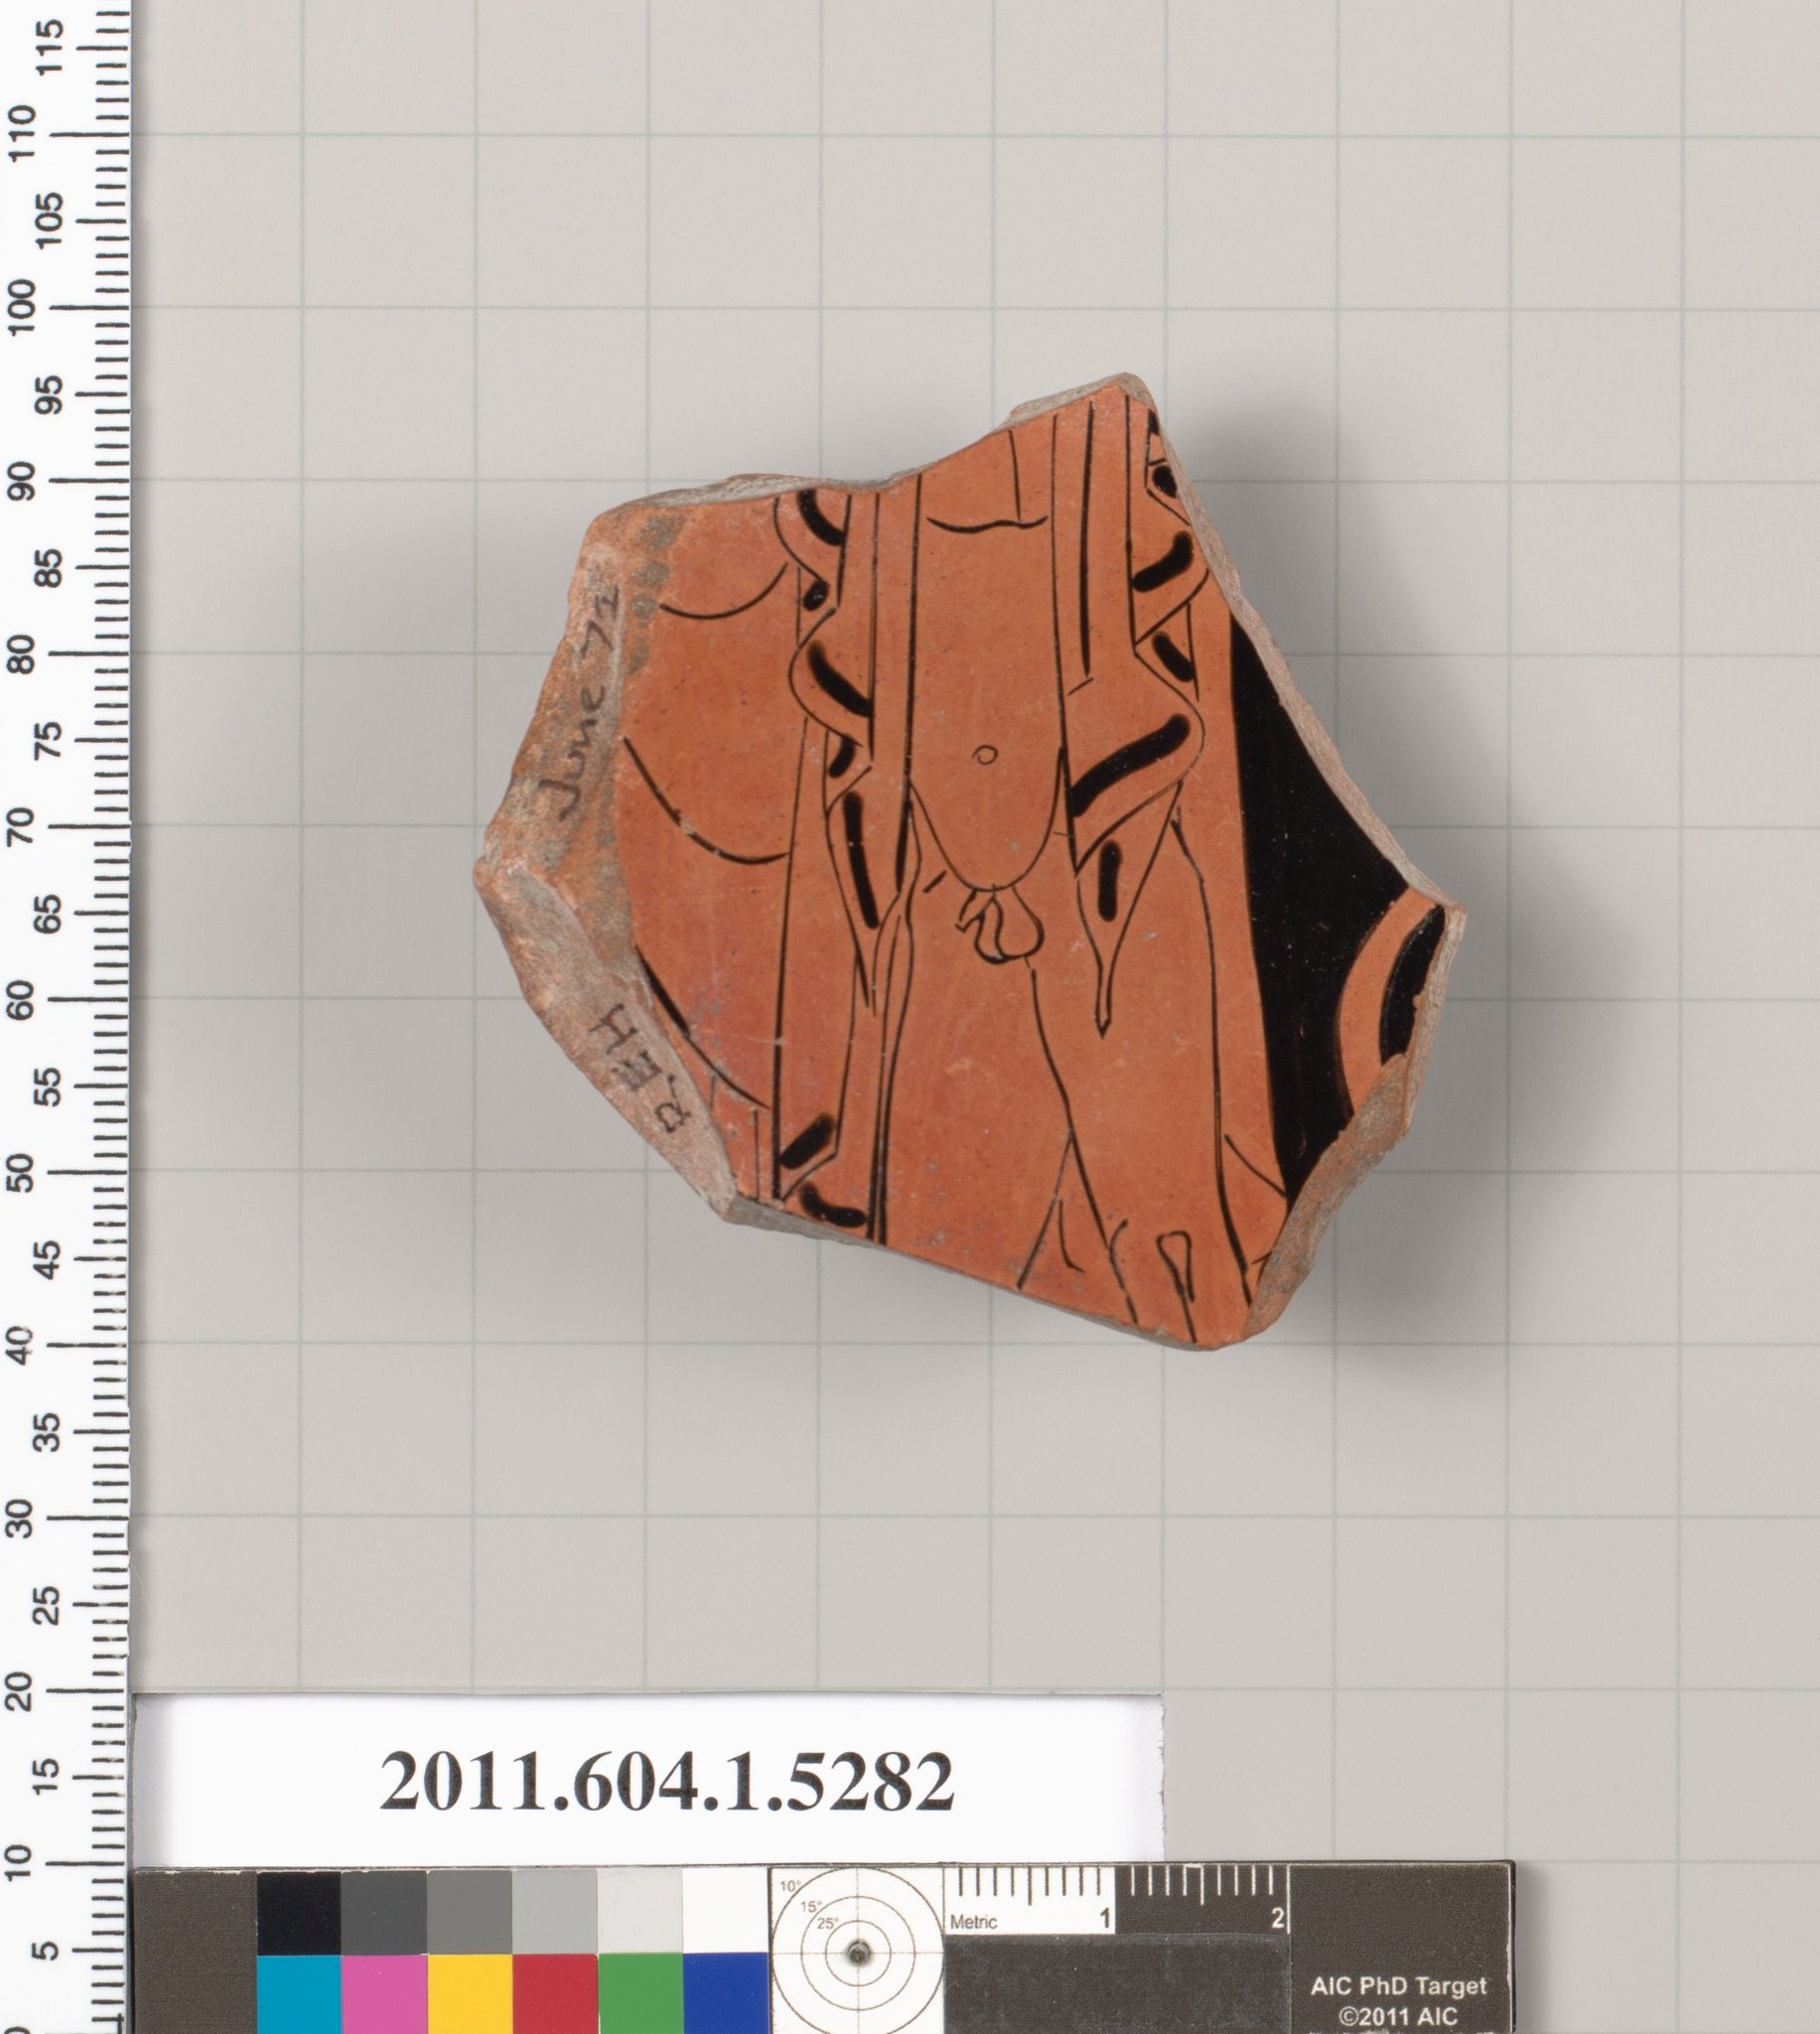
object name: kylix fragment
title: Terracotta fragment of a kylix (drinking cup)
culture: greek, attic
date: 480-470 BCE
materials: terracotta